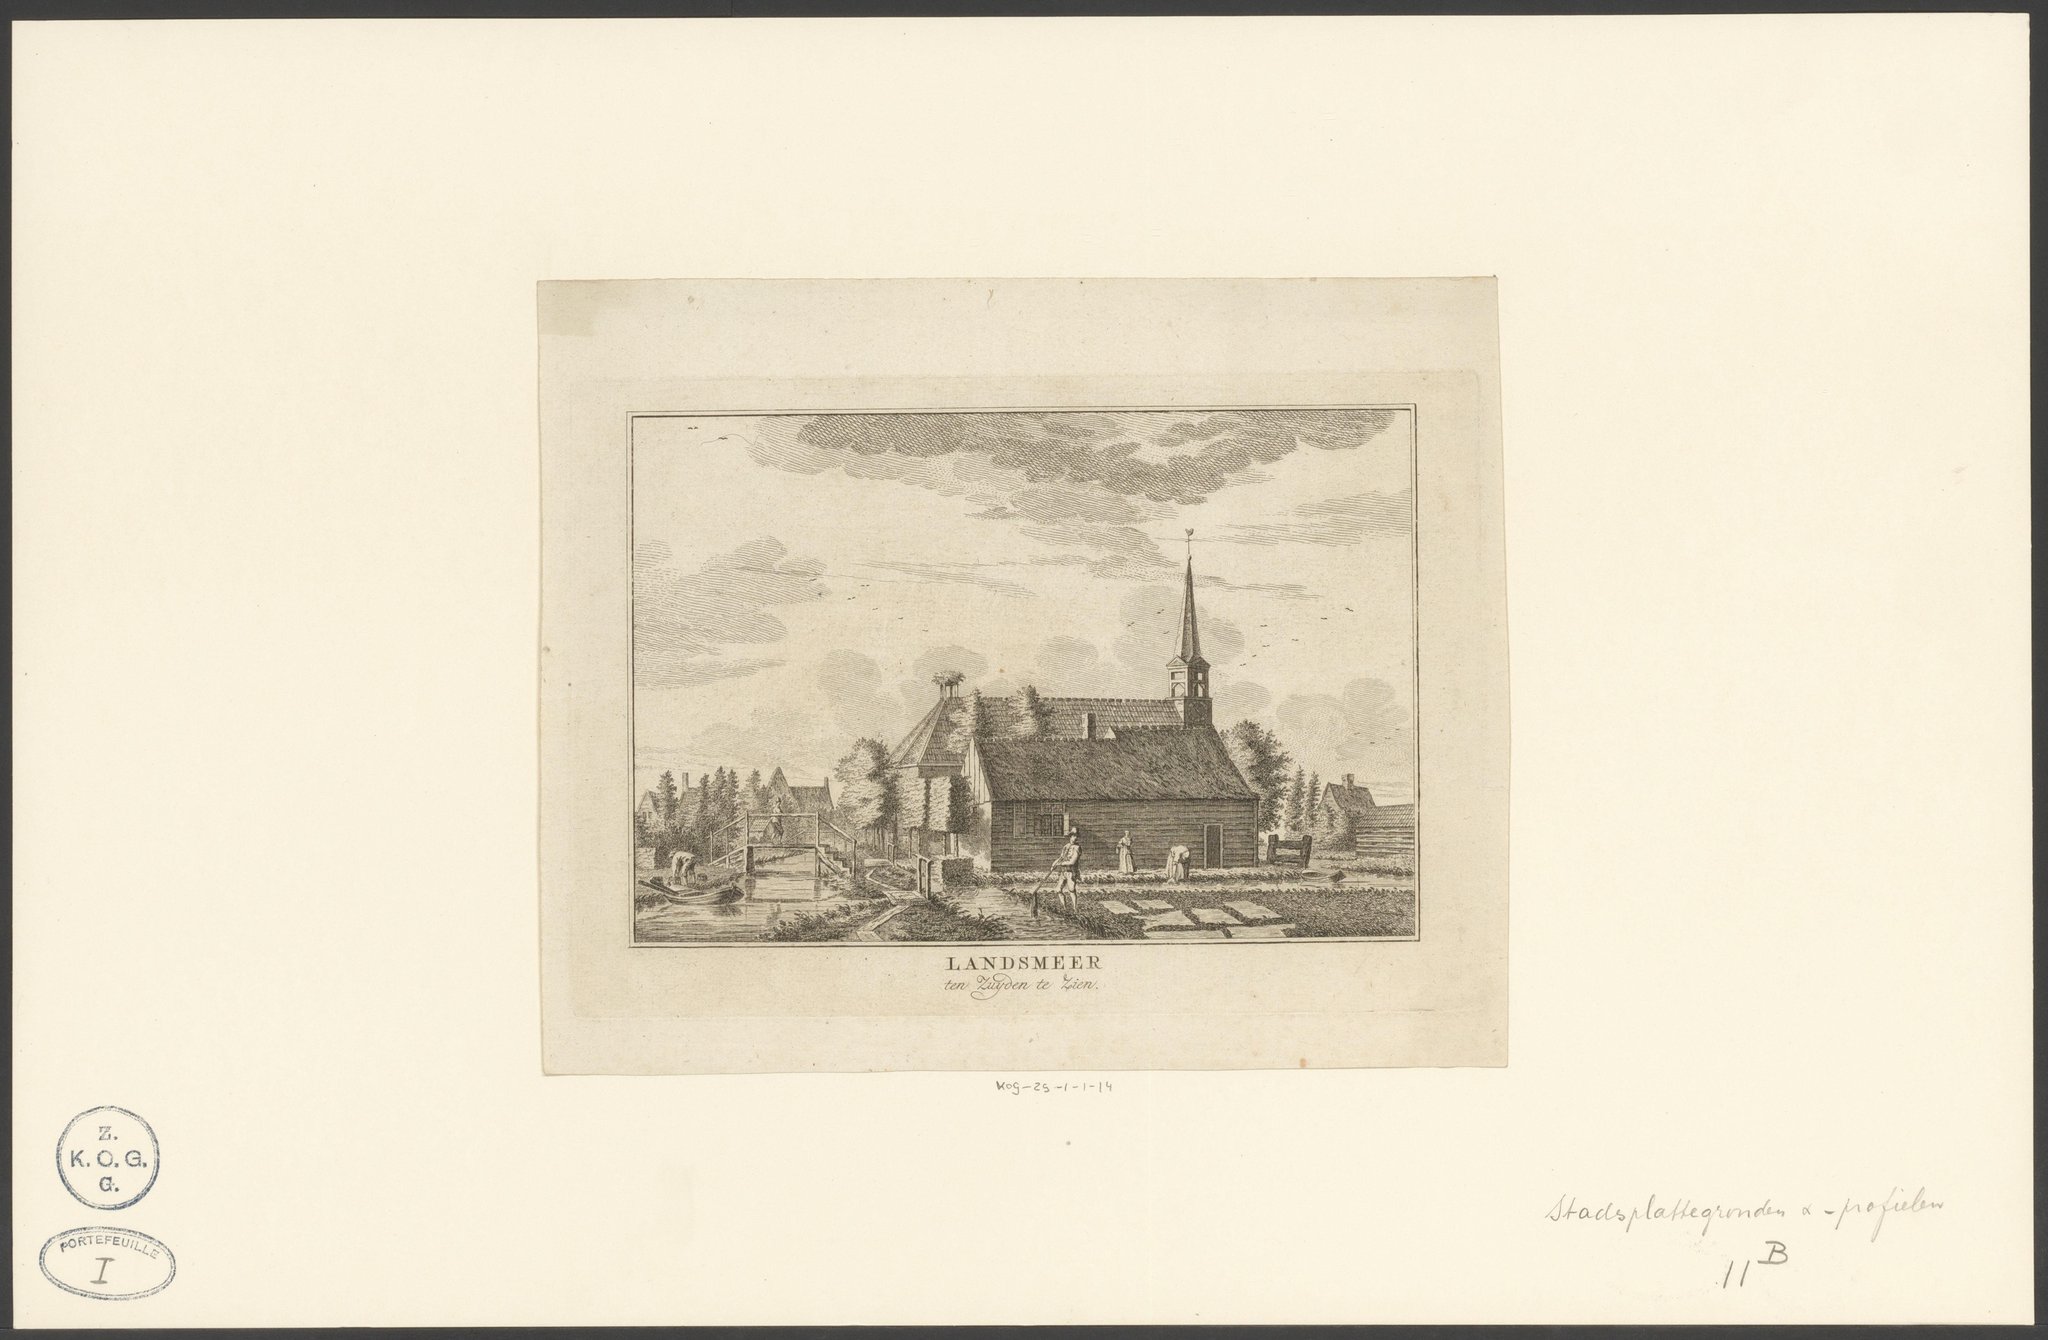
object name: print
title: Gezicht op Landsmeer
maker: Anonymous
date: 1700-1799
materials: paper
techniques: etching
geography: netherlands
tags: bleaching (laundering), public road in village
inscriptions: collector's mark, collector's mark: Lugt 1641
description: Gezicht op enkele gebouwen in het dorp Landsmeer. Op de voorgrond worden lakens te bleken gelegd. Onderwerpsrubrieken binnen de Atlas Zeden en Gewoonten: topografie; profielen.